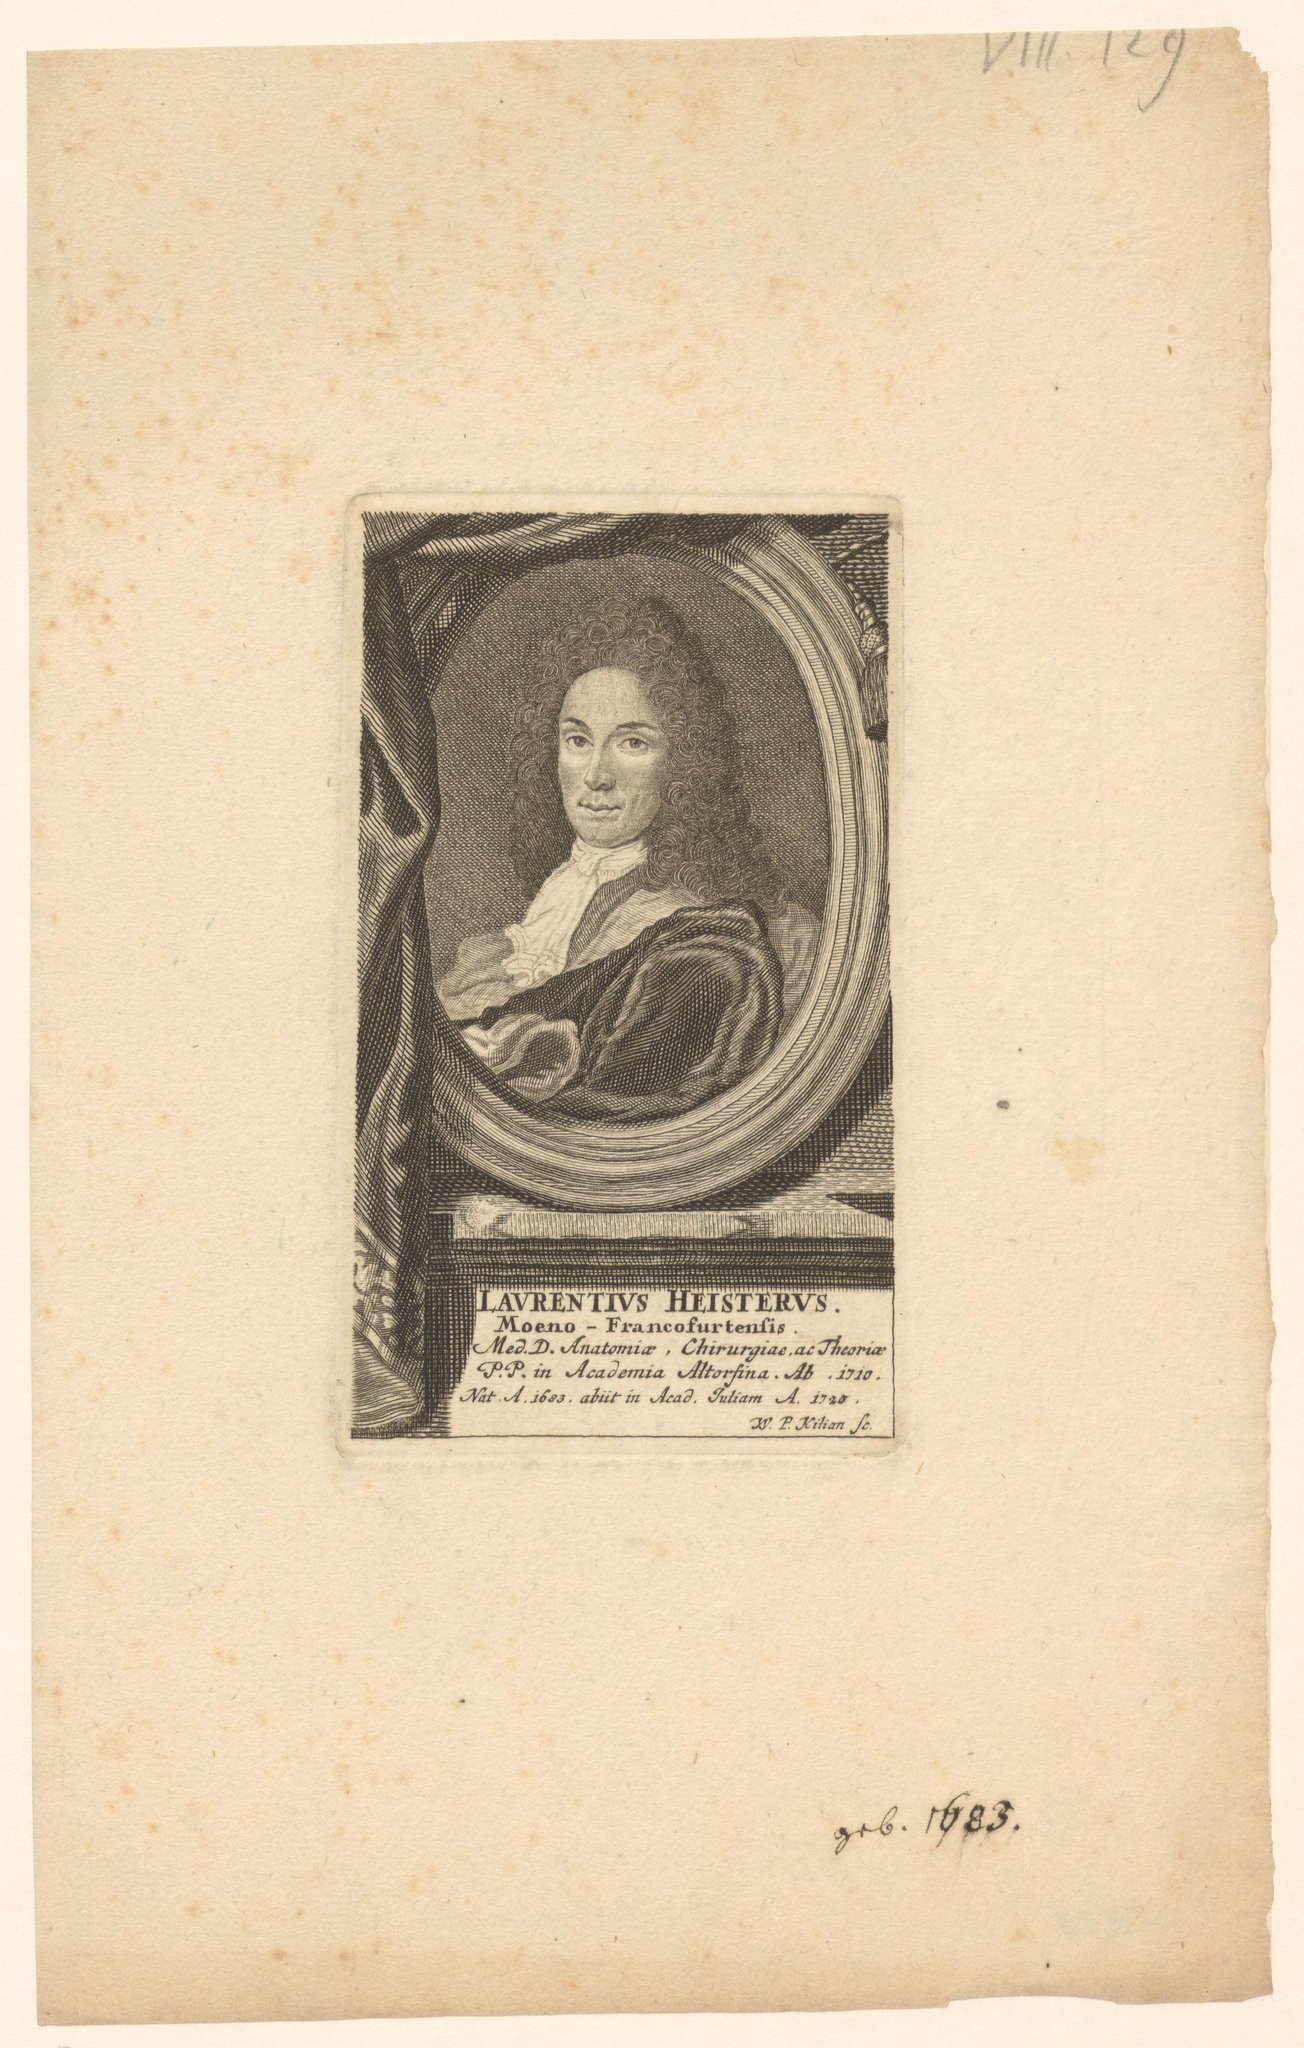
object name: print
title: Portret van Lorenz Heister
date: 1720-1728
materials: paper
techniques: engraving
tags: further education (+ portrait of teacher, professor), historical persons, physician, doctor (+ portrait of scholar, scientist)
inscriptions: collector's mark: Lugt 2228